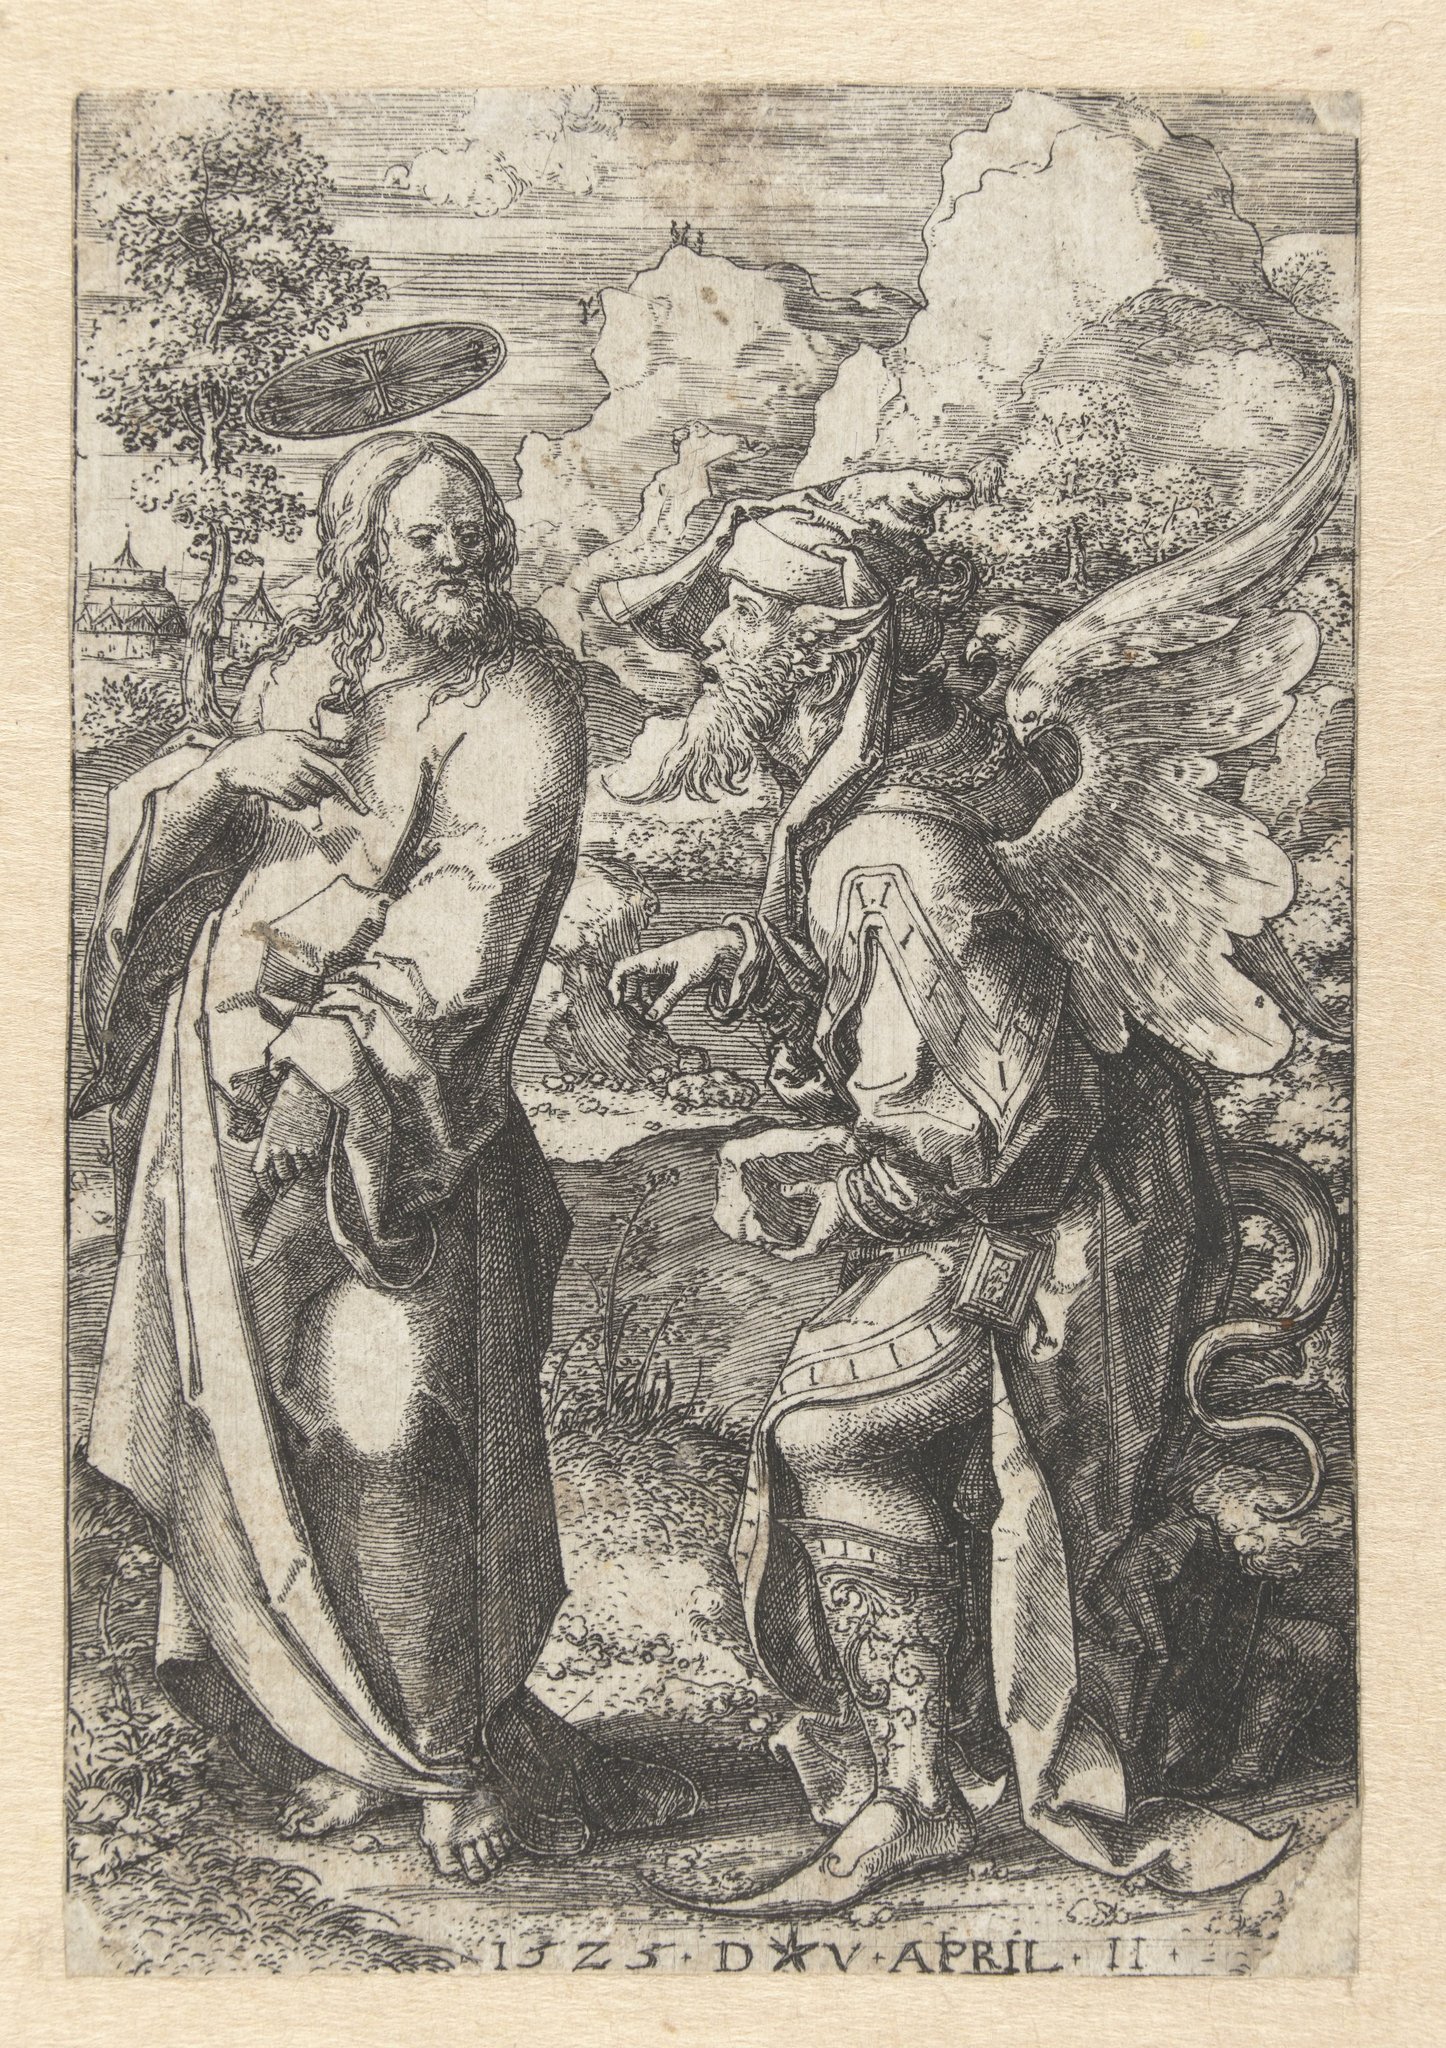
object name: print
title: Verzoeking van Christus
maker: dirck vellert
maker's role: draughtsman, painter, print maker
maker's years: 1480-1547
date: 1525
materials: paper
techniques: engraving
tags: 'command these stones to become loaves of bread' ~ temptation of christ in the wilderness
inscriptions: collector's mark: Lugt 2228aa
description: Landschap met Christus en de duivel met vleugels en staart. De Duivel houdt een steen vast. Op de achtergrond valt iemand van een berg.